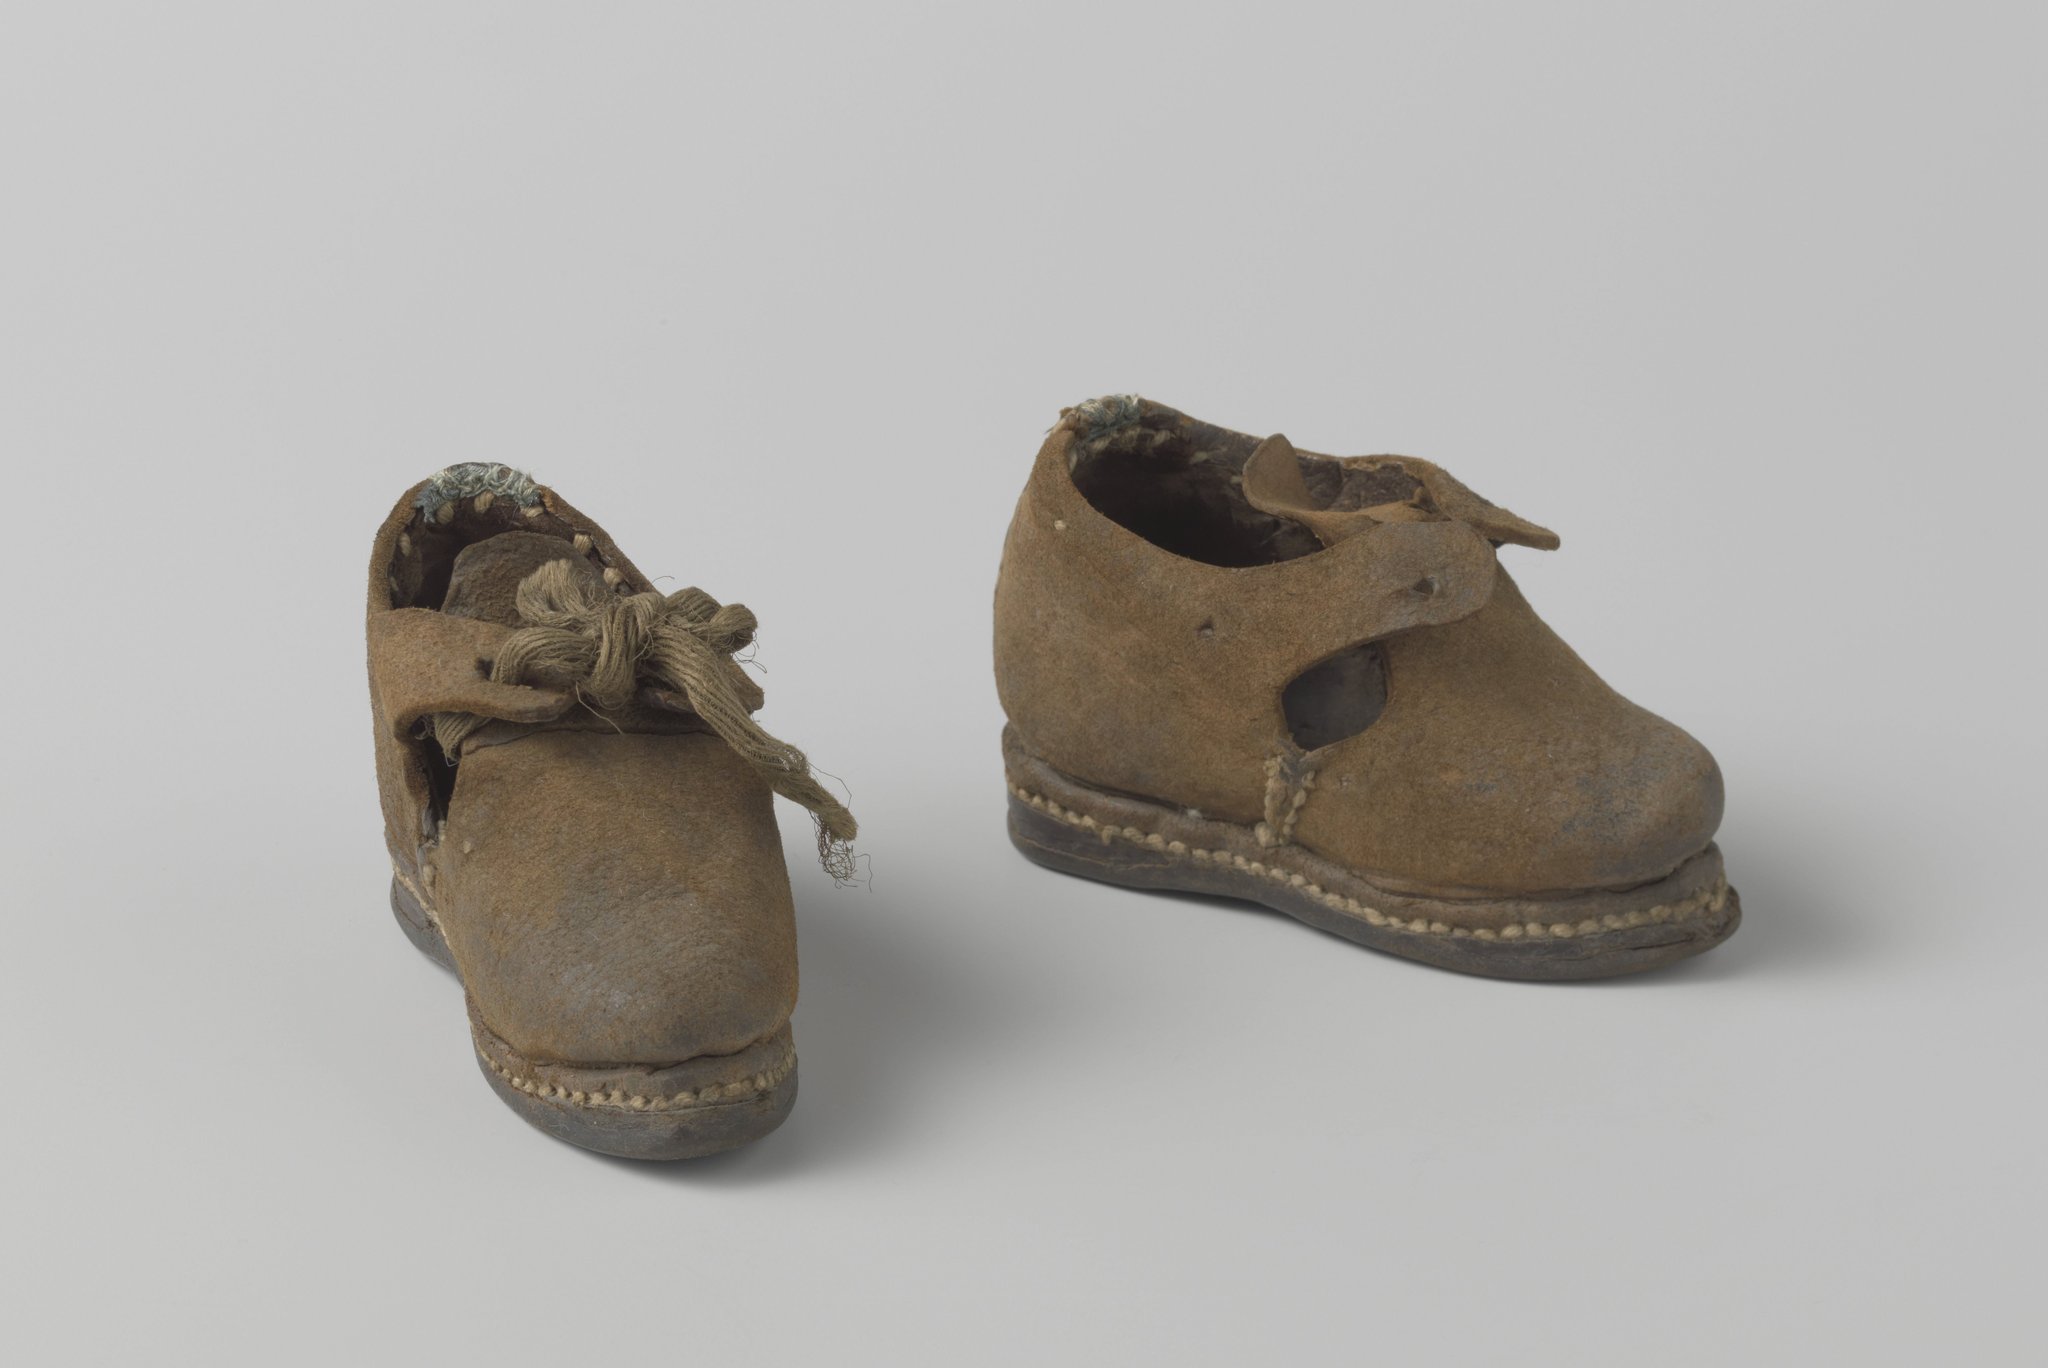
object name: shoe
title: Schoen van beige leer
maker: Anonymous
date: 1600-1699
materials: leather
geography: netherlands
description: Schoen (poppenschoenen?) van beige leer. Doorlopende zool met ingebouwde hak van laagje leer. Sluiting hoog op de wreef met tong en twee lippen. Bijeen gehouden door zijden lint.